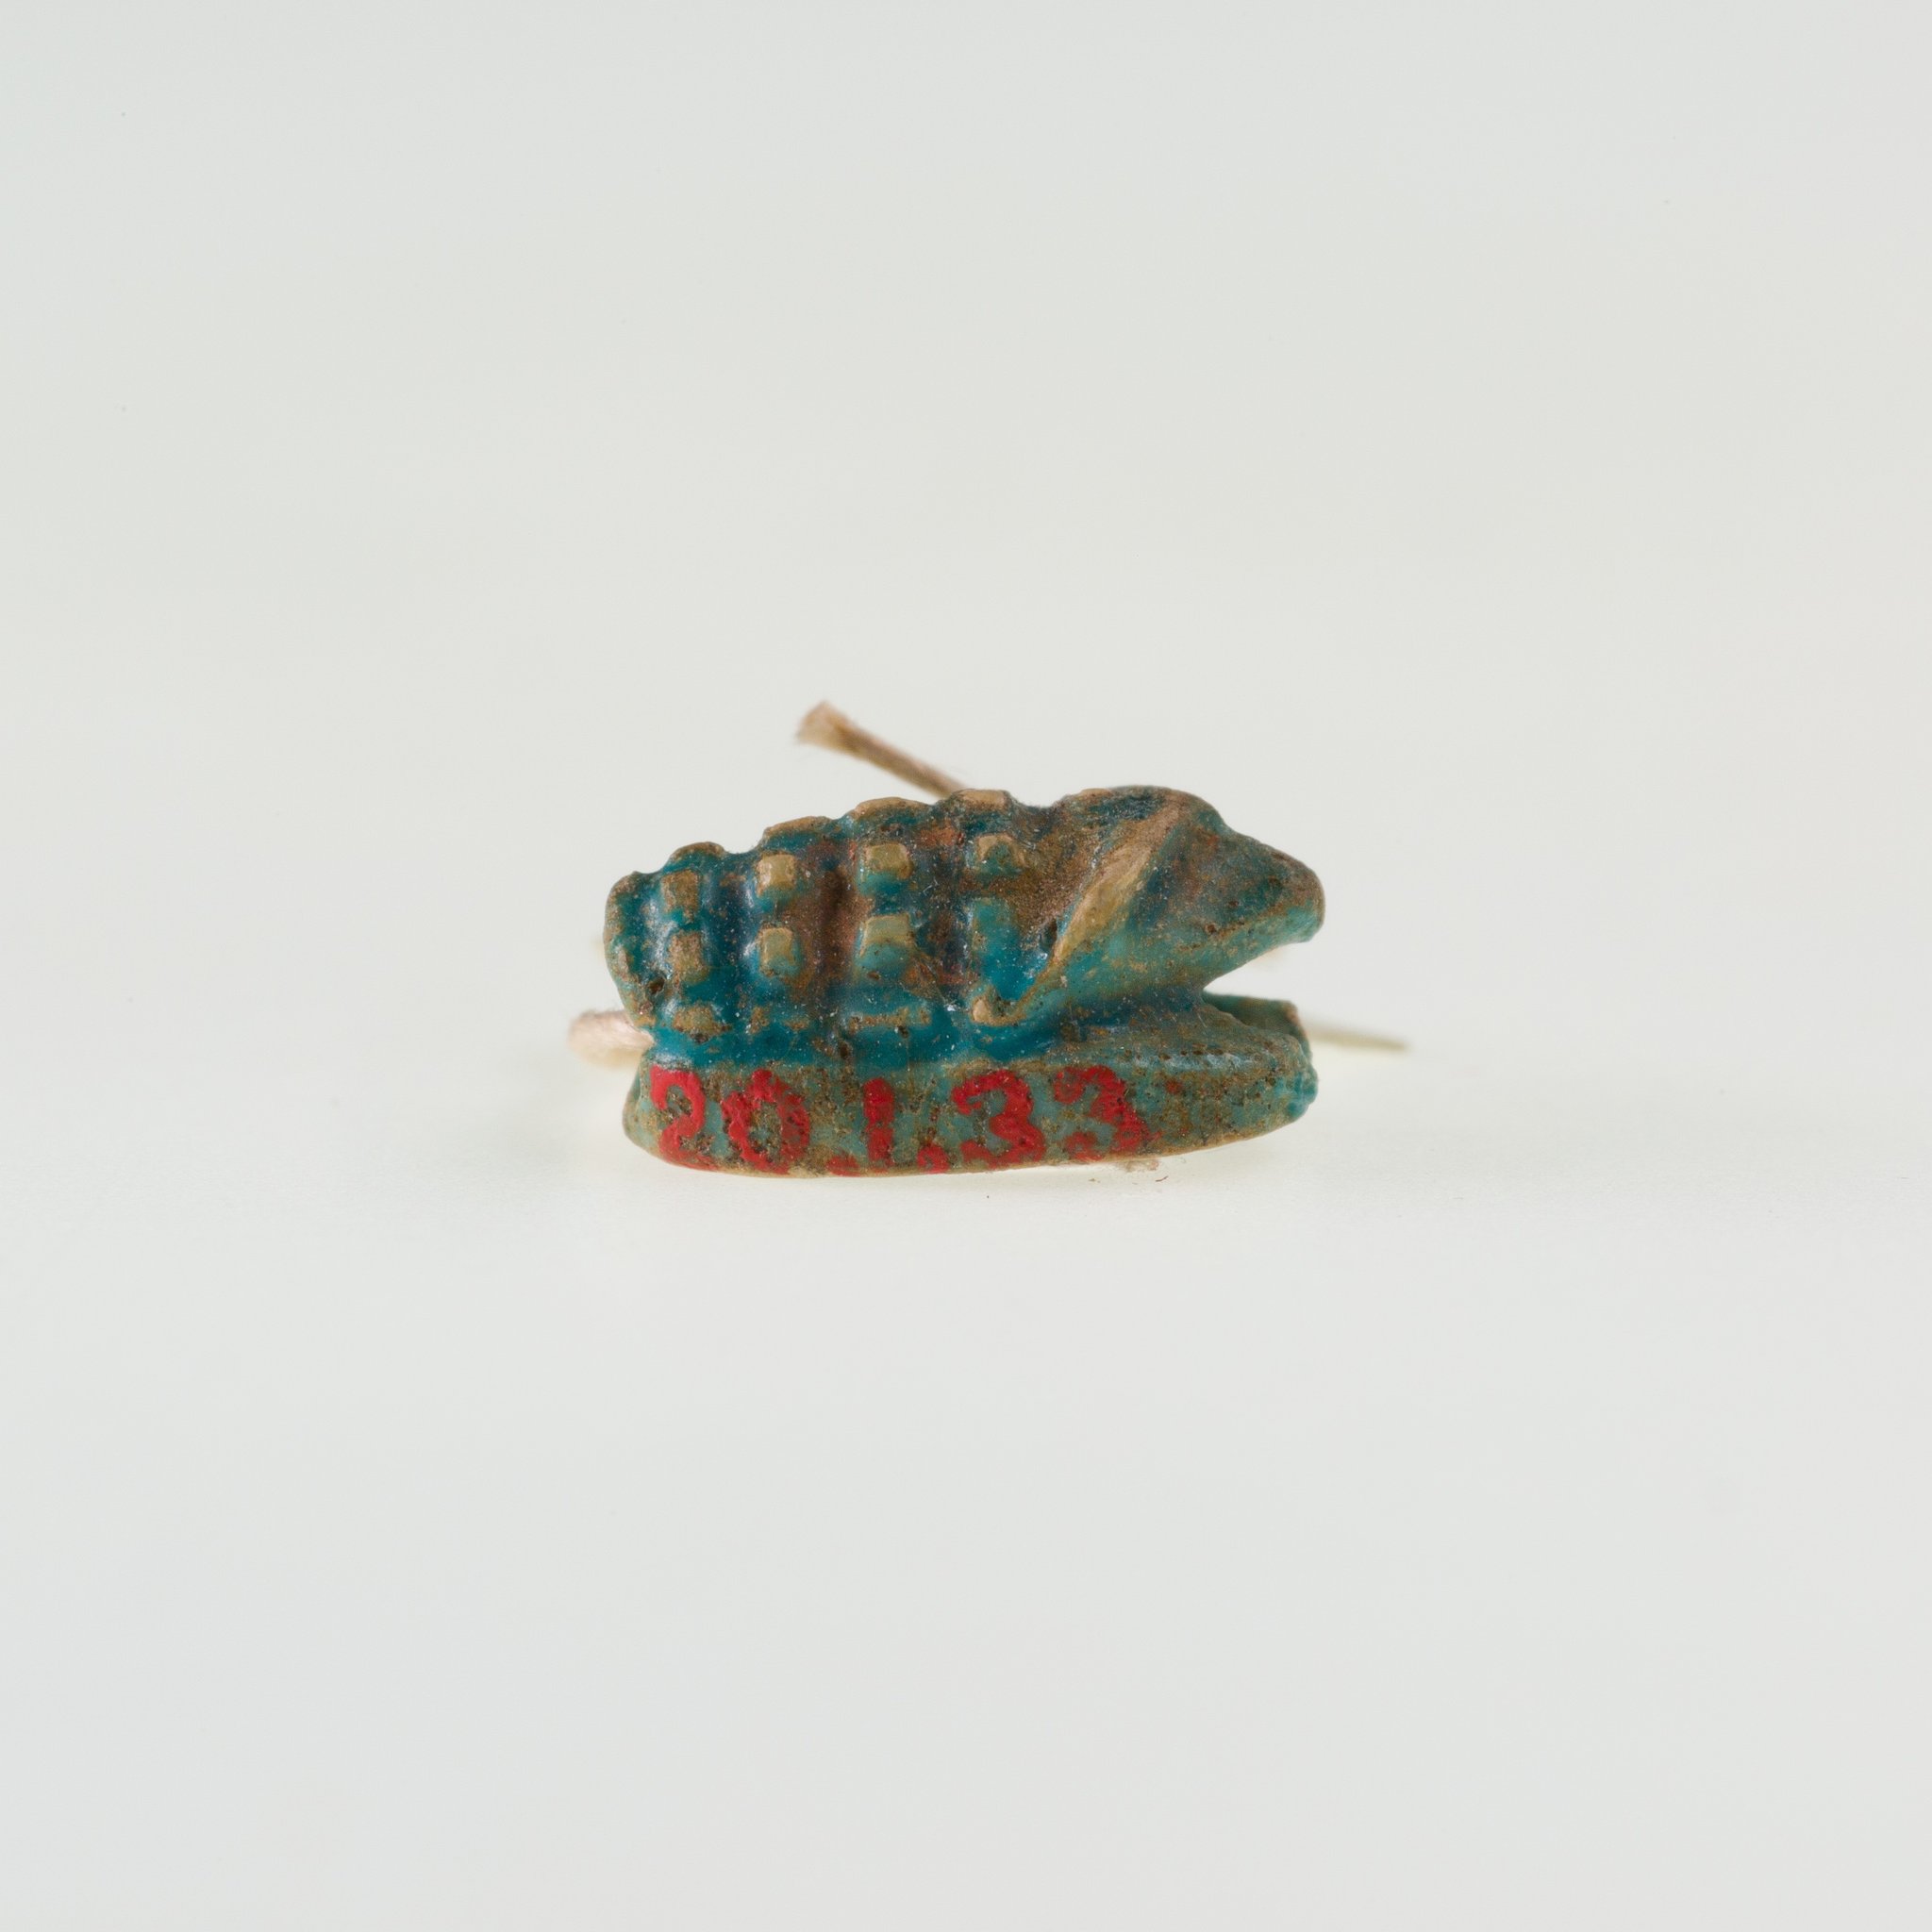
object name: scaraboid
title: Scaraboid in form of hedgehog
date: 1981-1295 BCE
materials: stone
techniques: glazing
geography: egypt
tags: animals